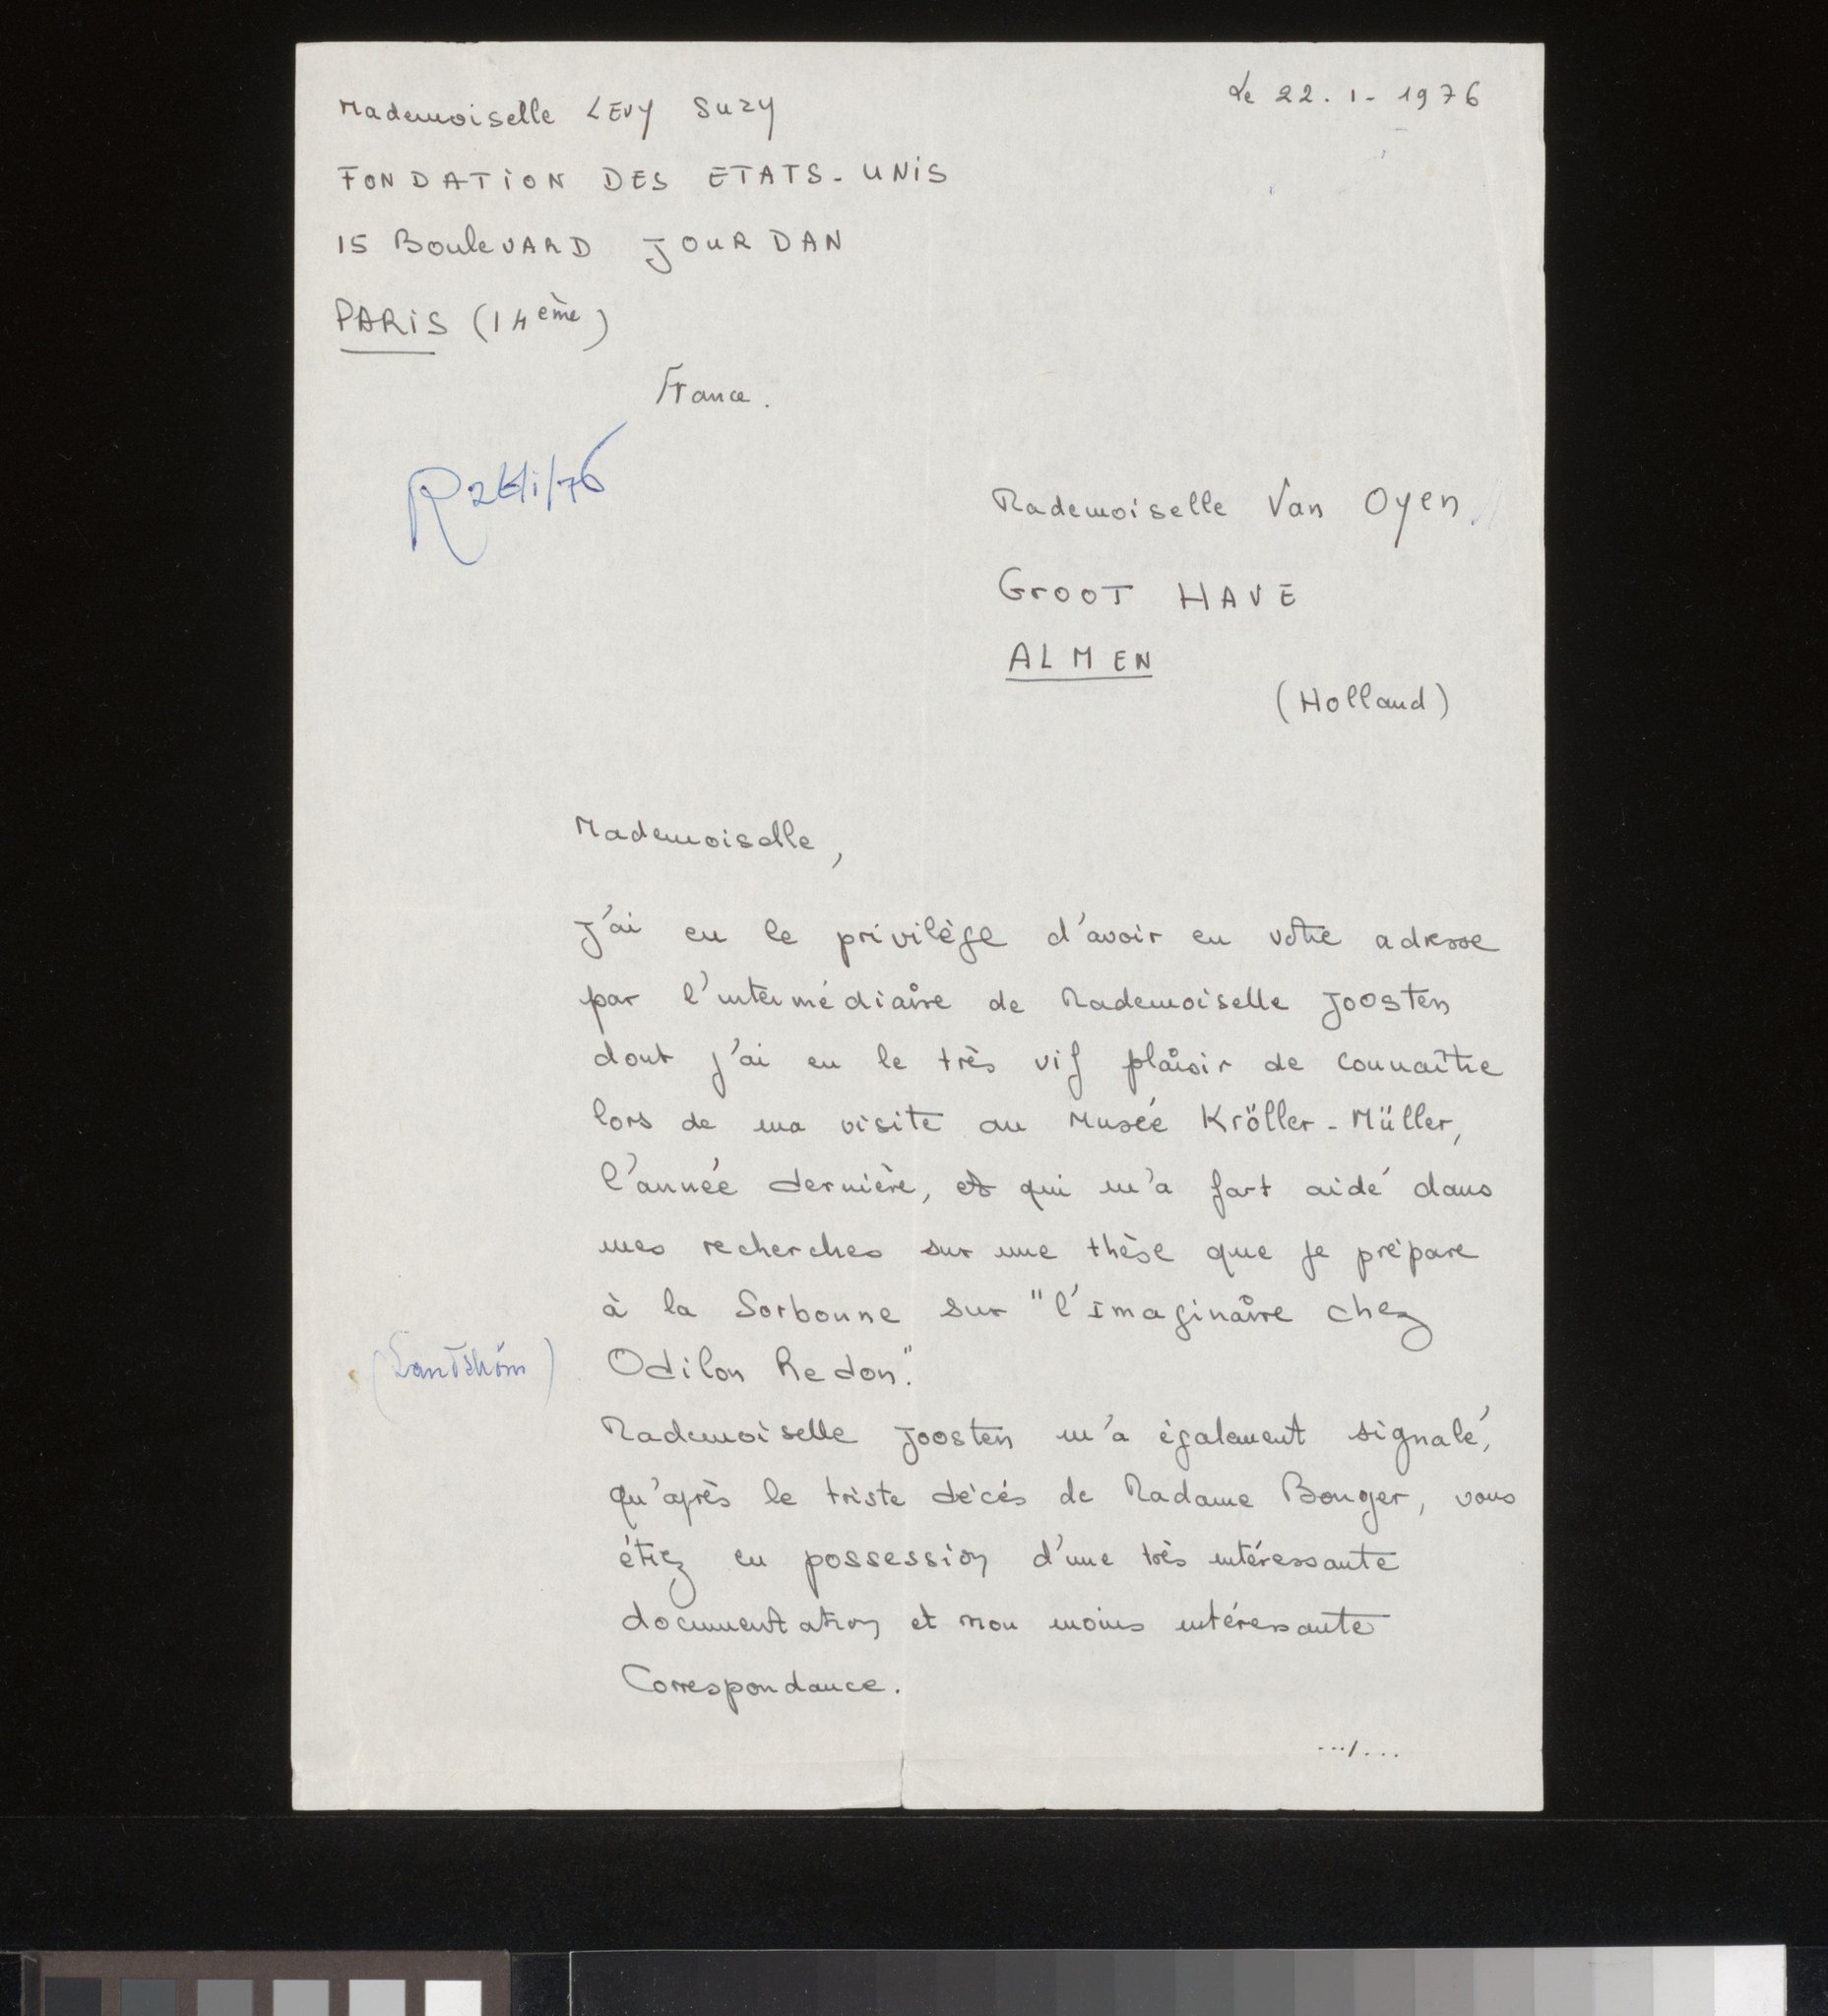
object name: letter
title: Brief aan mevrouw van Oyen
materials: ink, paper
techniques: pen, writing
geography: paris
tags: suze van oyen, paris, painter, print maker, draughtsman, odilon redon, françoise w.m. bonger, middelburg, bram hammacher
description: Brief bevat een conceptbrief van Suze van Oyen aan Suzy Levy.